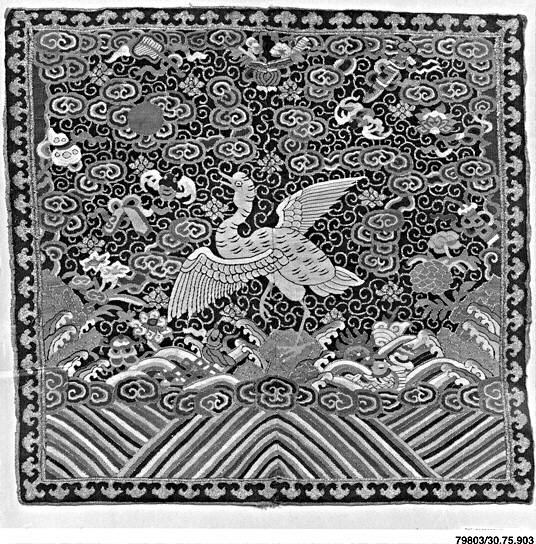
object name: rank badge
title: Rank Badge with Wild Goose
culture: chinese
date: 1767-1833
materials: metal thread, silk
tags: bats,geese